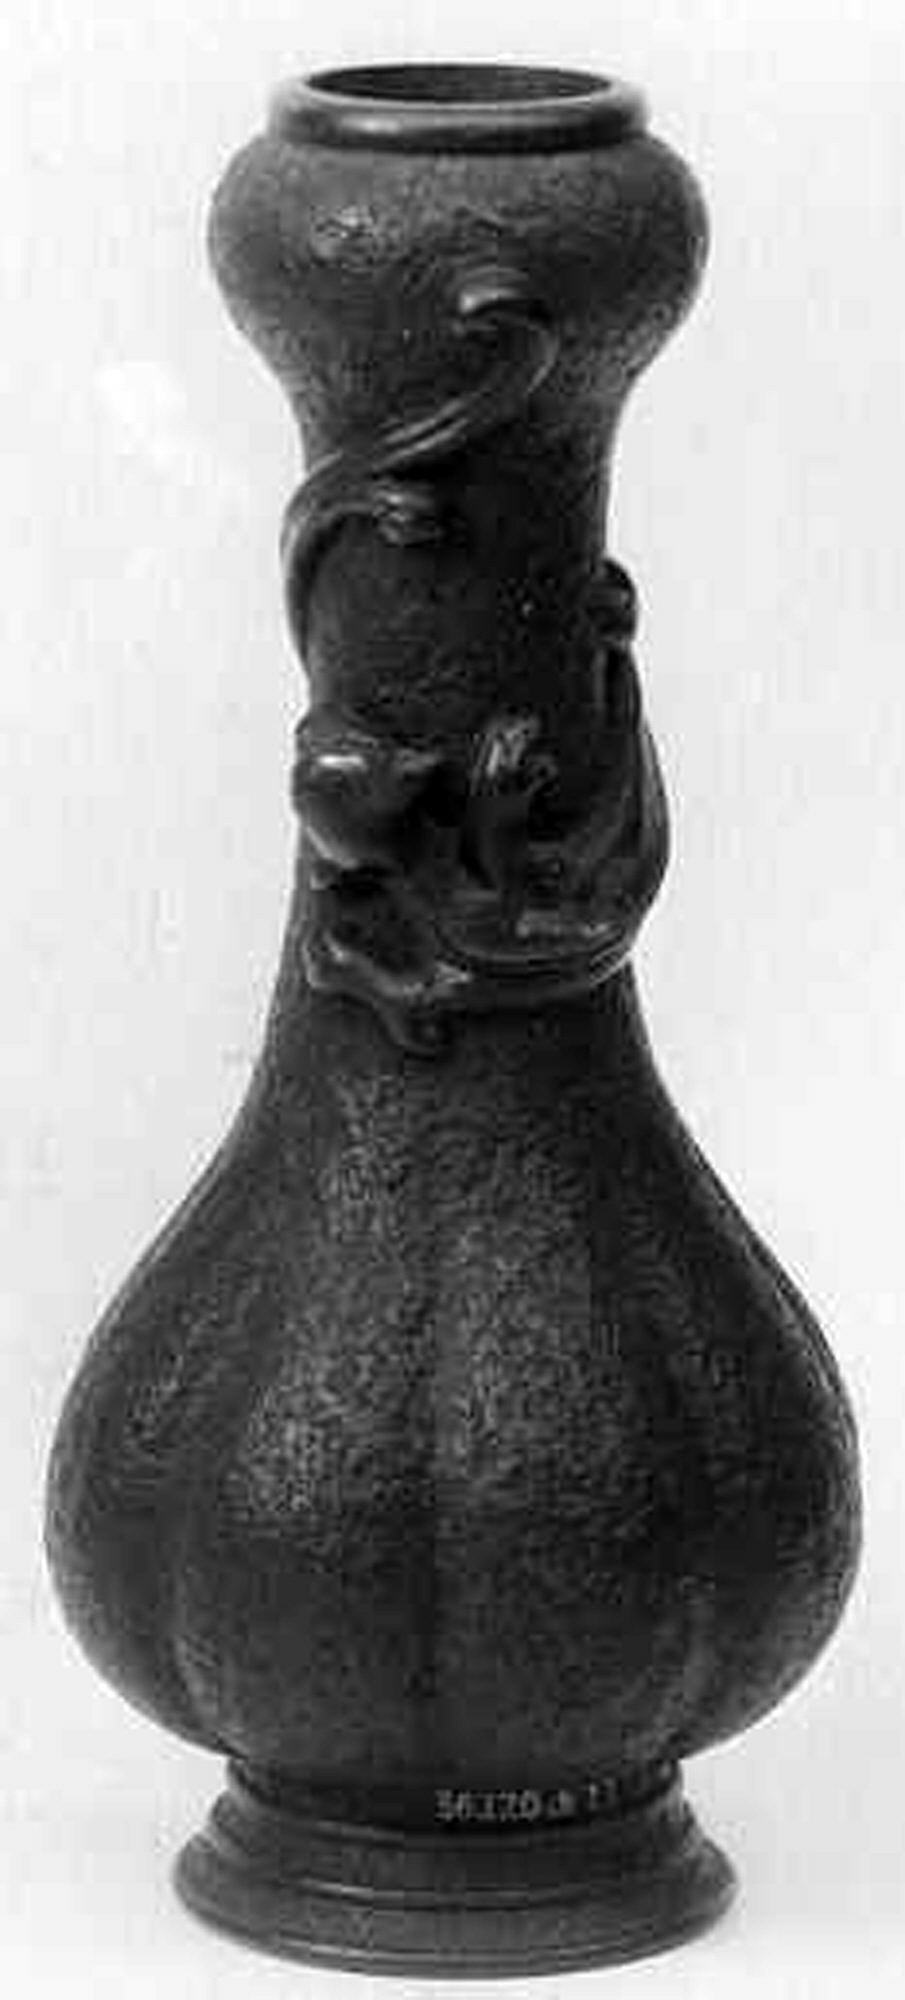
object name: vase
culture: japanese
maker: takakazu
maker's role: artist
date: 1501-1600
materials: iron